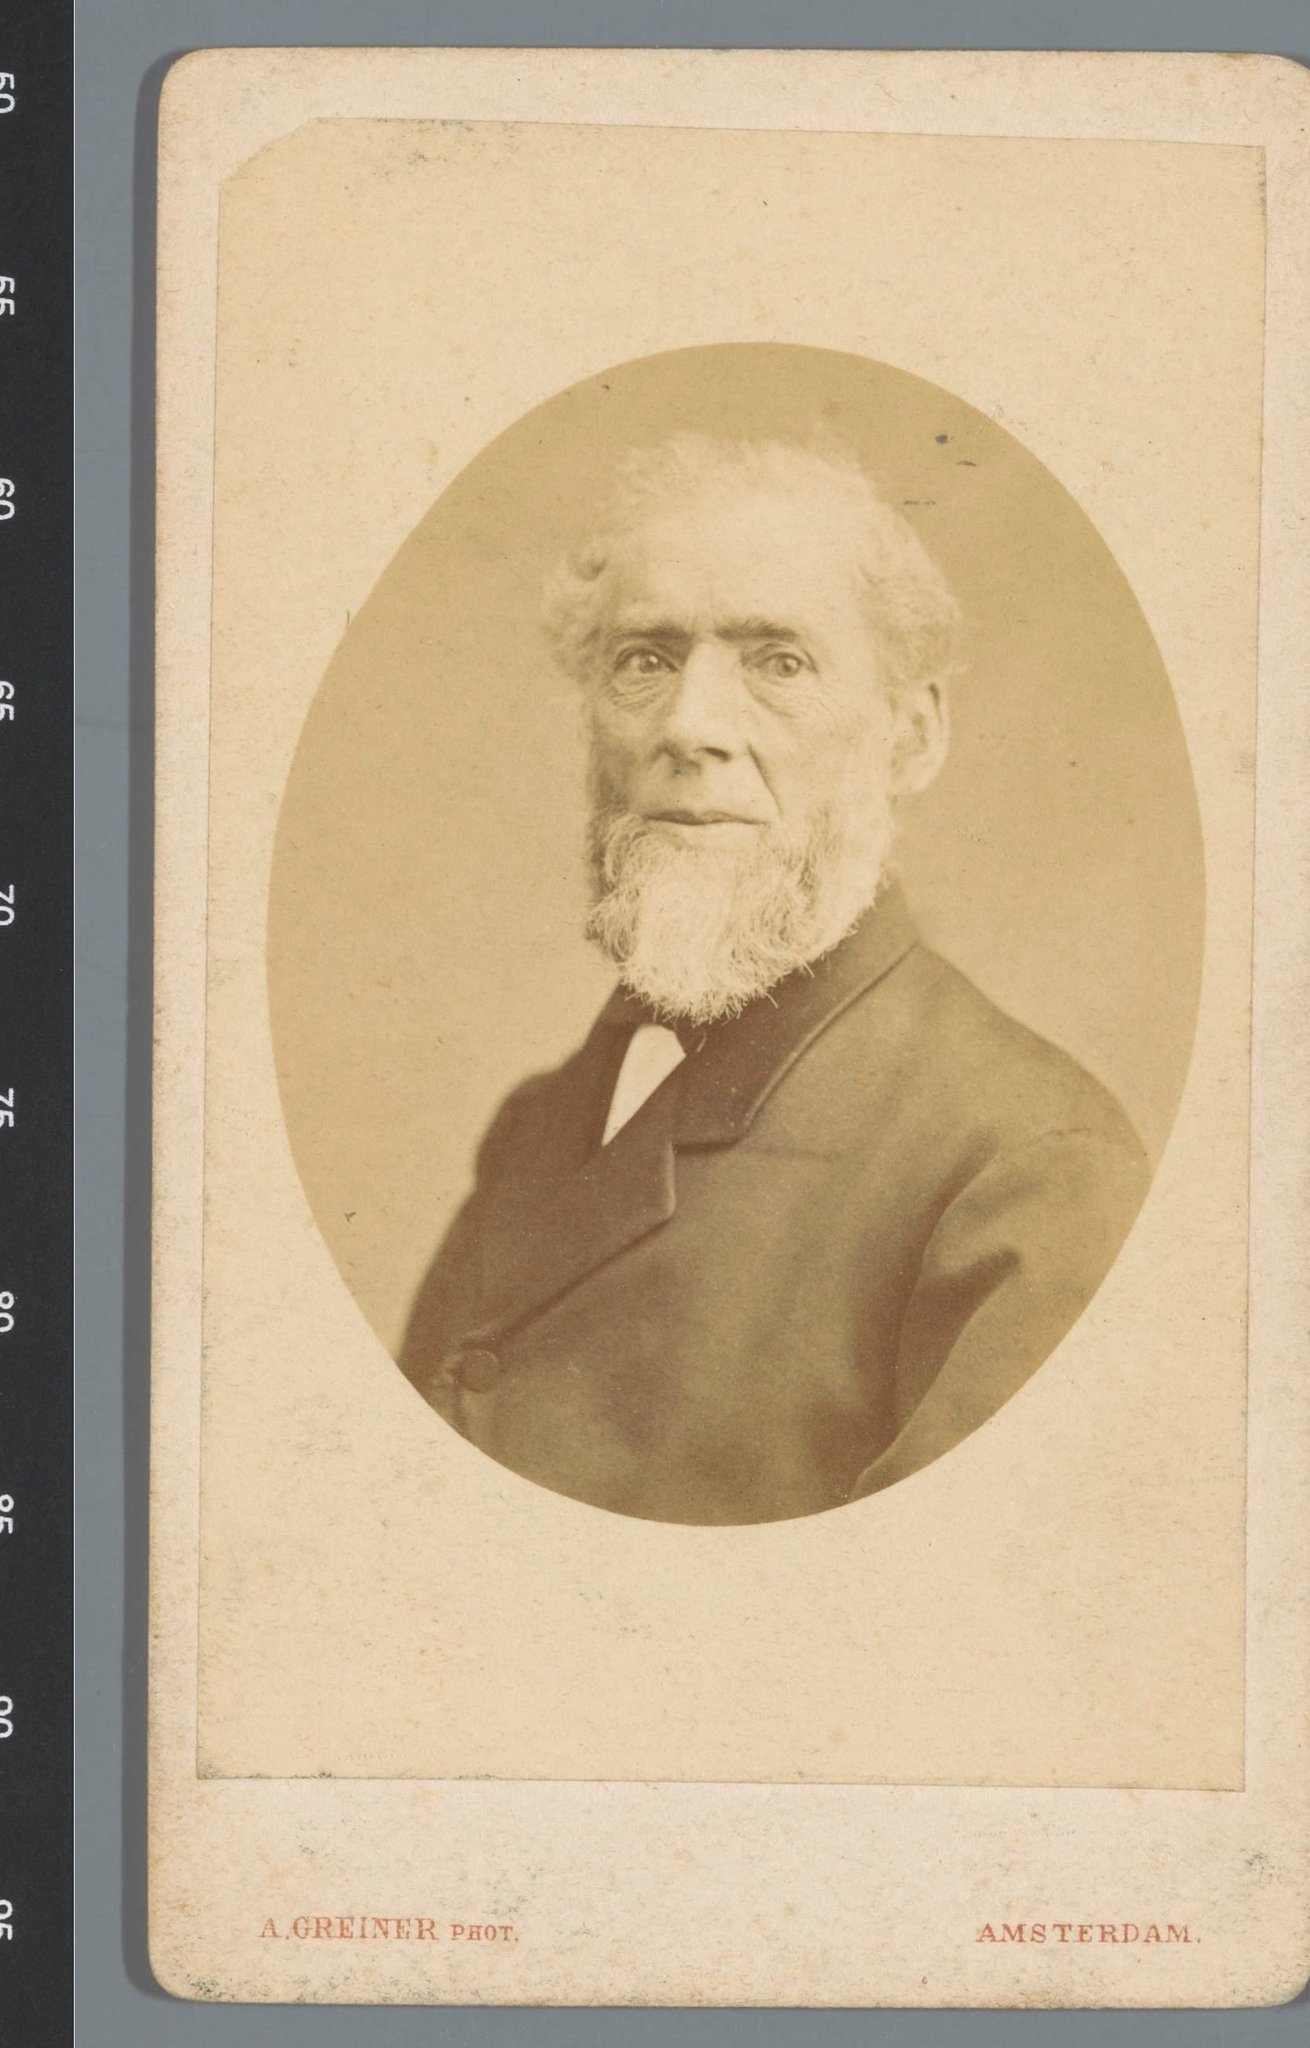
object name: photograph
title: Portret van een onbekende man met baard, aangeduid als de heer Verheij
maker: albert greiner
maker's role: fotograaf, fotostudio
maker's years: 1833-1890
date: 1861-1874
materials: cardboard, paper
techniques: albumen print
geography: amsterdam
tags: historical persons, old man, beard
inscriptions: inscription: ‘Verheij’, inscription: ‘AG/ A. GREINER/ Photograf/ NIEUWENDIJK L. 87/ AMSTERDAM.’